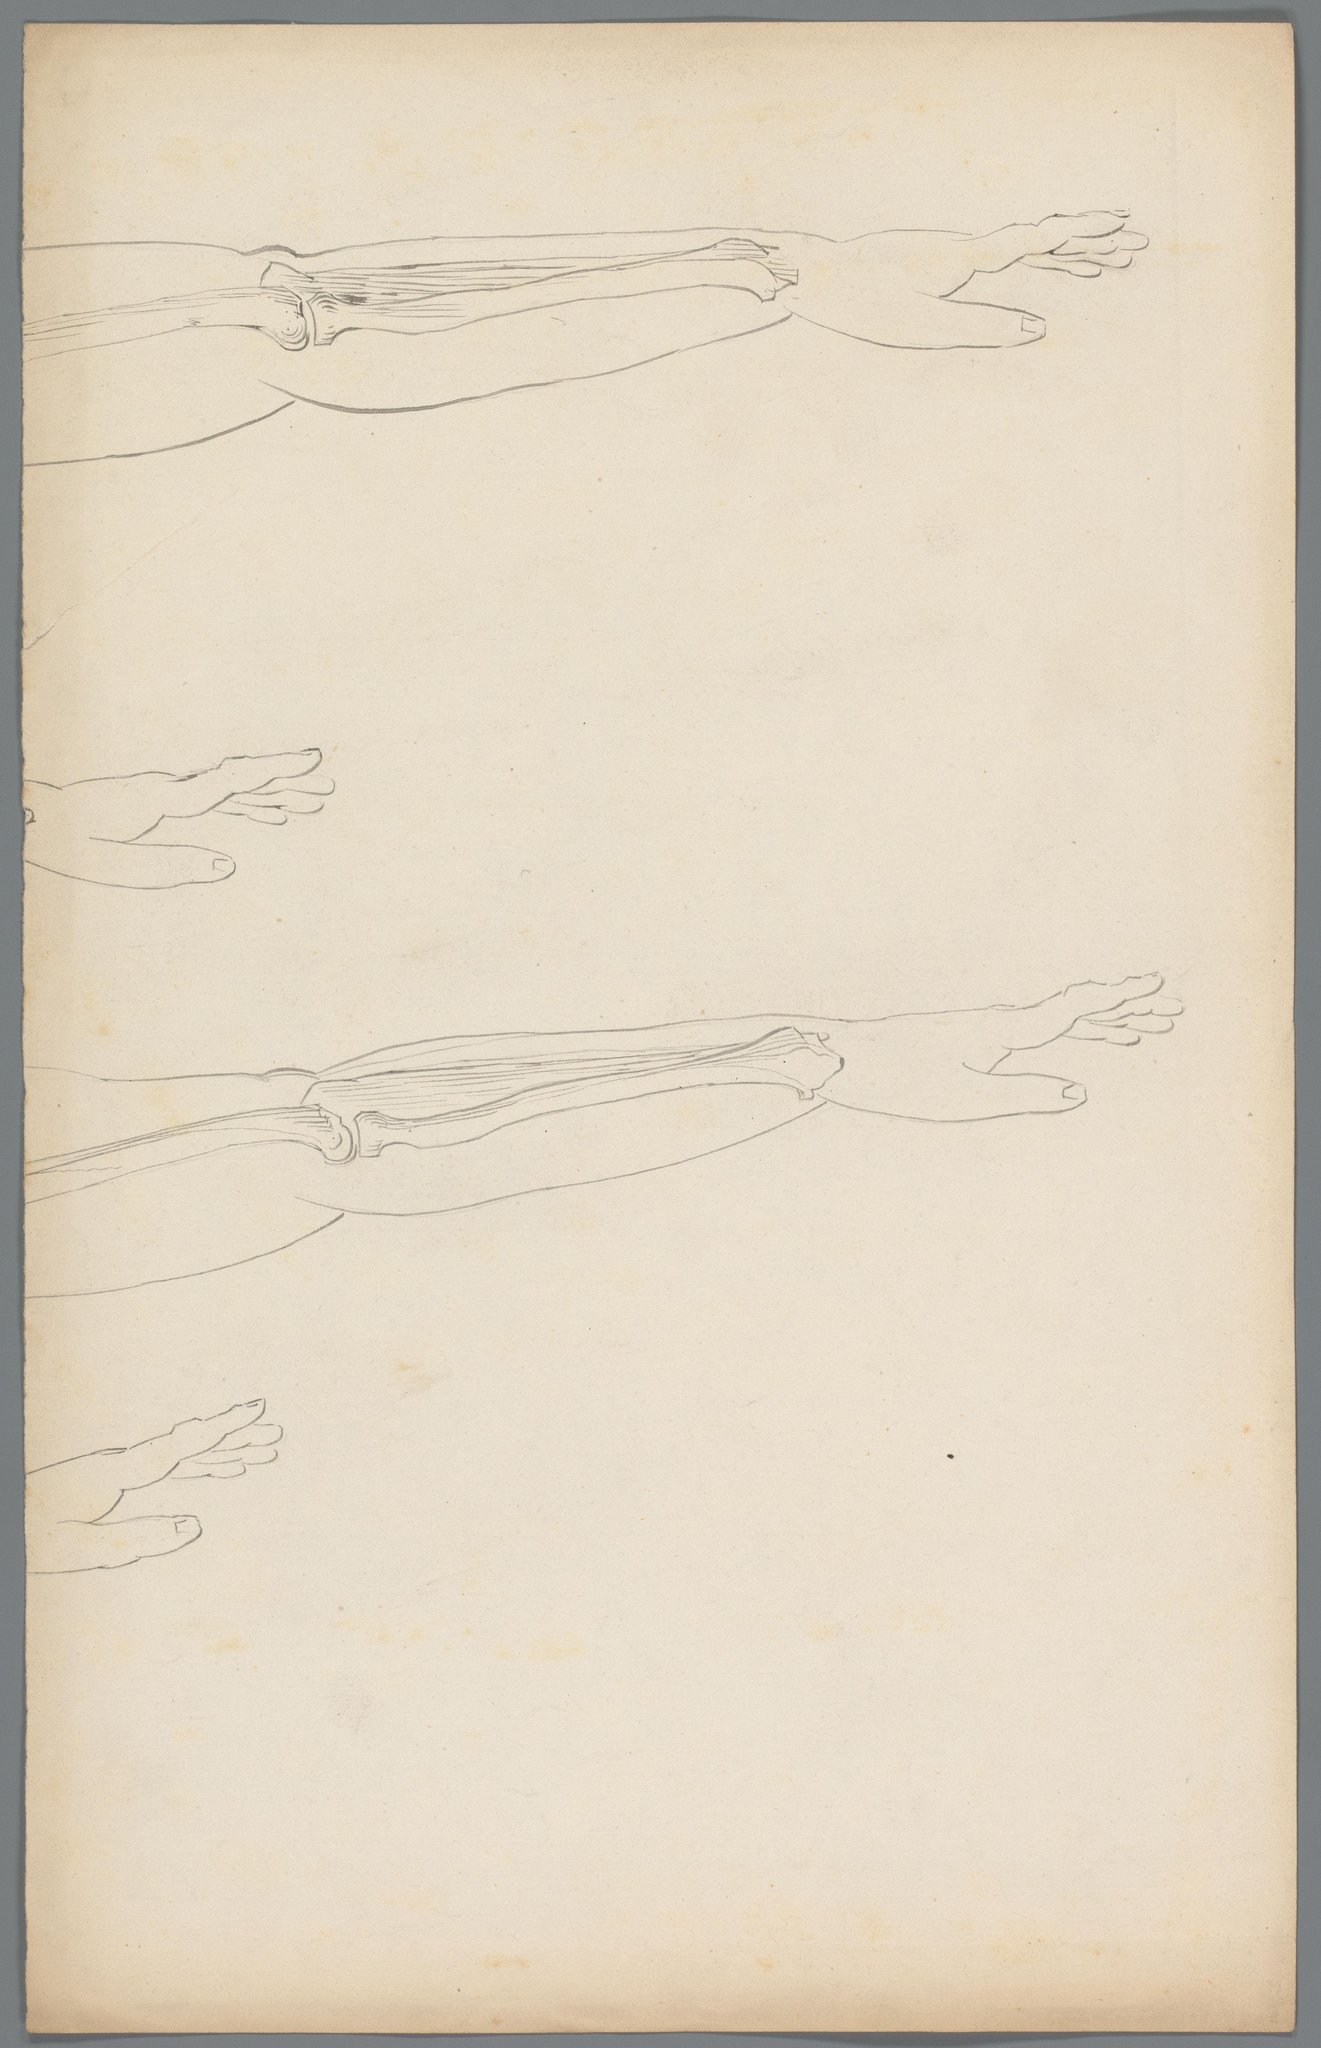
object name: drawing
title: Studies van de botten in een arm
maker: jacobus everhardus josephus van den berg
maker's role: draughtsman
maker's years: 1802-1861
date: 1812-1861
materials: ink, paper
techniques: pen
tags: arms, bones of the arms